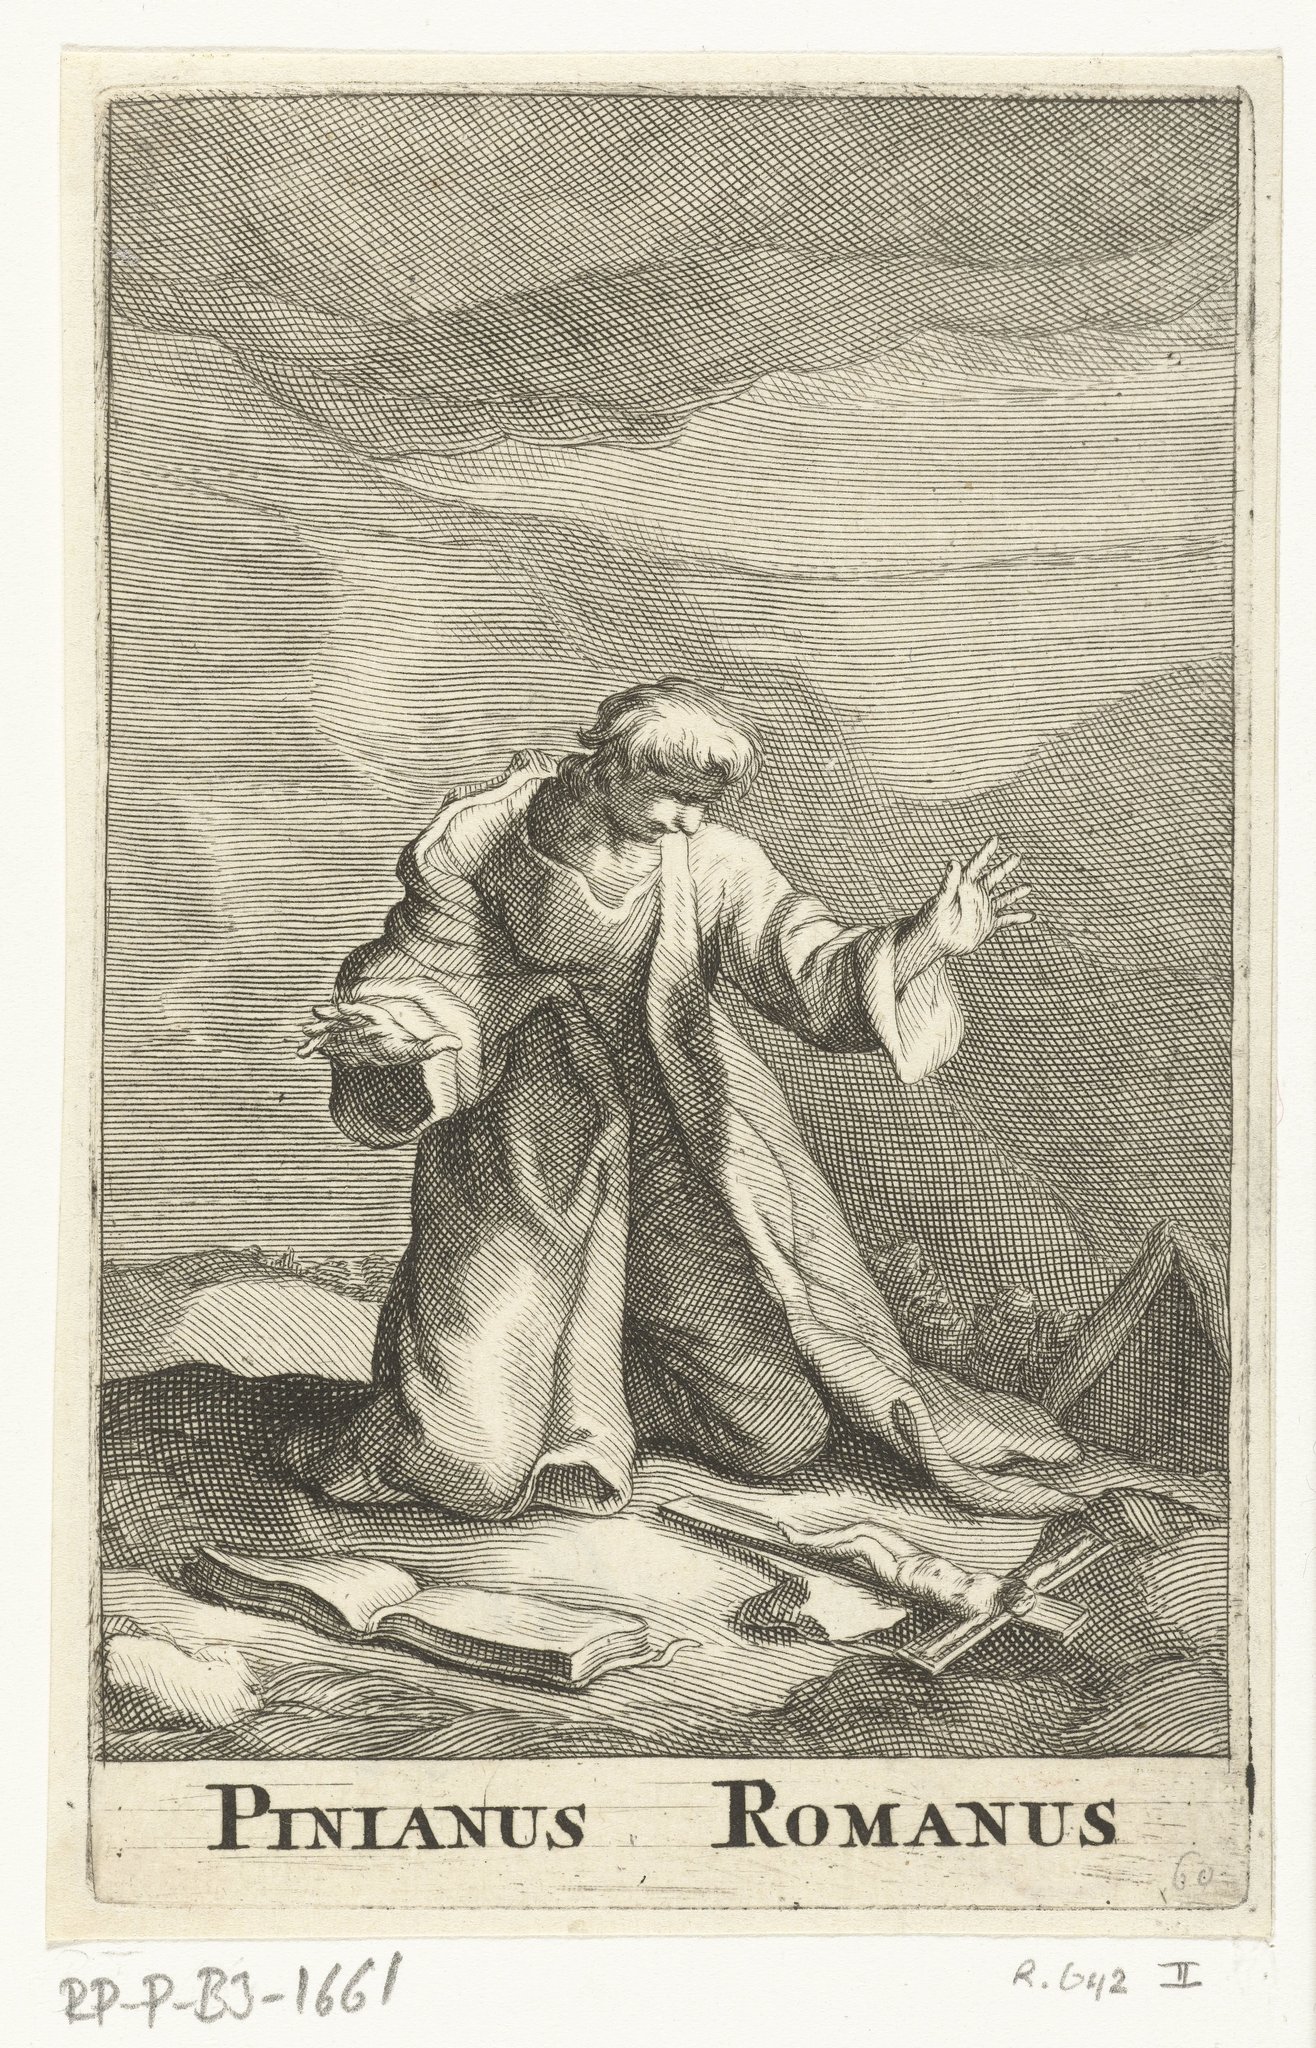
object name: print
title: Pinianus Romanus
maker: frederick bloemaert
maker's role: print maker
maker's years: 1614-1669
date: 1636-1670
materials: paper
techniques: engraving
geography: utrecht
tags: male saints (with name)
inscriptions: collector's mark: Lugt 240, number: ‘60’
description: De heilige Pinian van Rome knielend op de grond op een heuveltje. Voor hem een open boek en een kruisbeeld. Prent uit een serie van 80 prenten en een titelprent met kluizenaars uit de 2e tot de 6e eeuw.